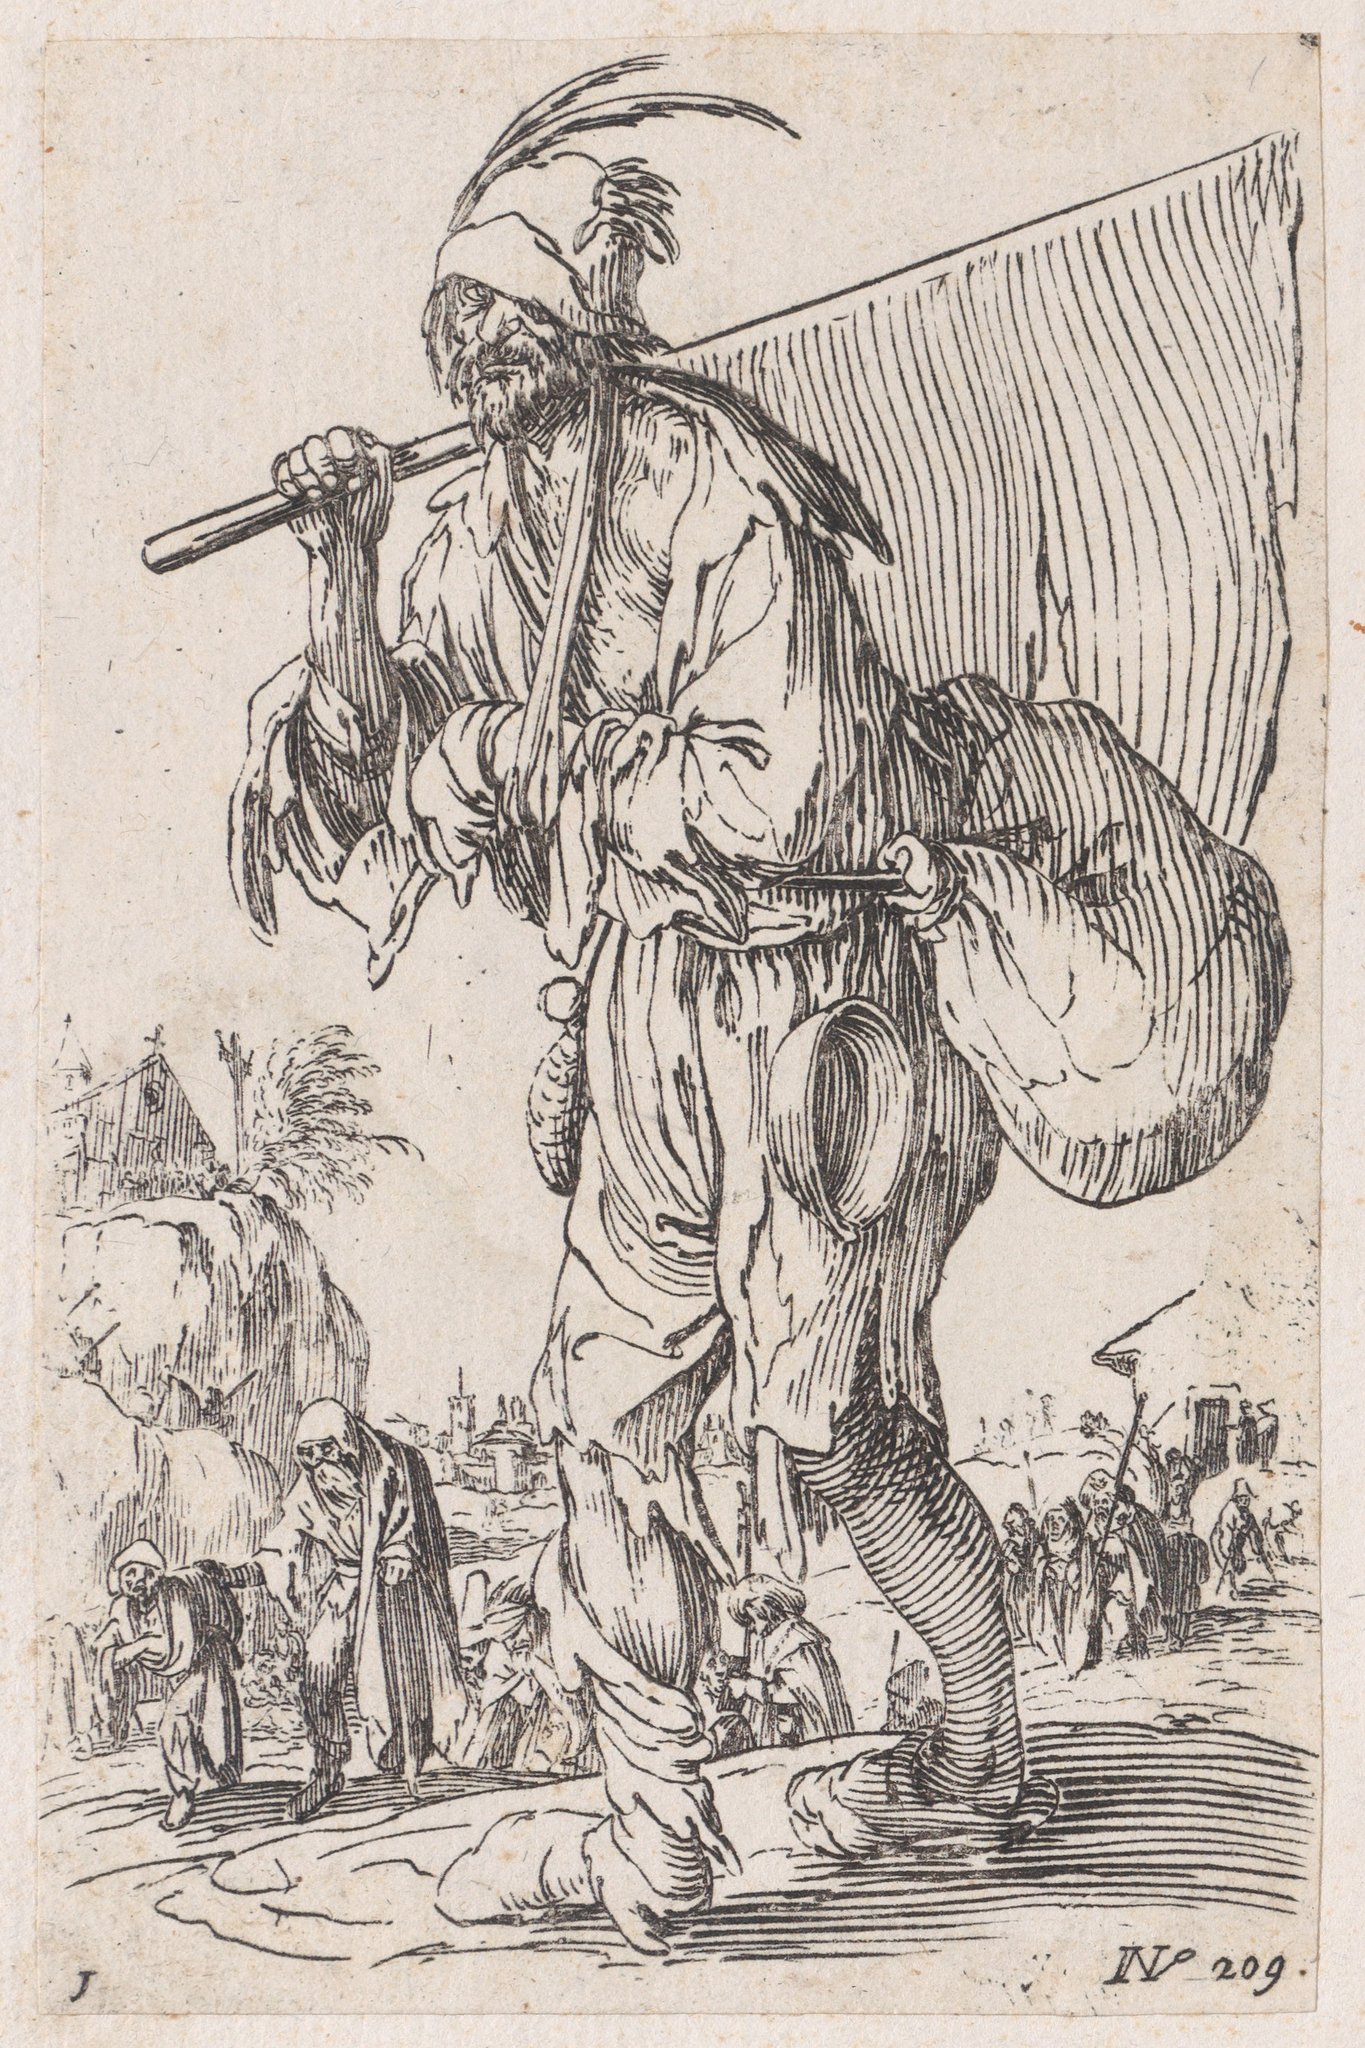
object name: print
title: Reverse Copy of Frontispiece, from Les Gueux suite appelée aussi Les Mendiants, Les Baroni, ou Les Barons (The Beggars, also called the Barons)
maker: Anonymous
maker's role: artist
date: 1601-1700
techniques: etching